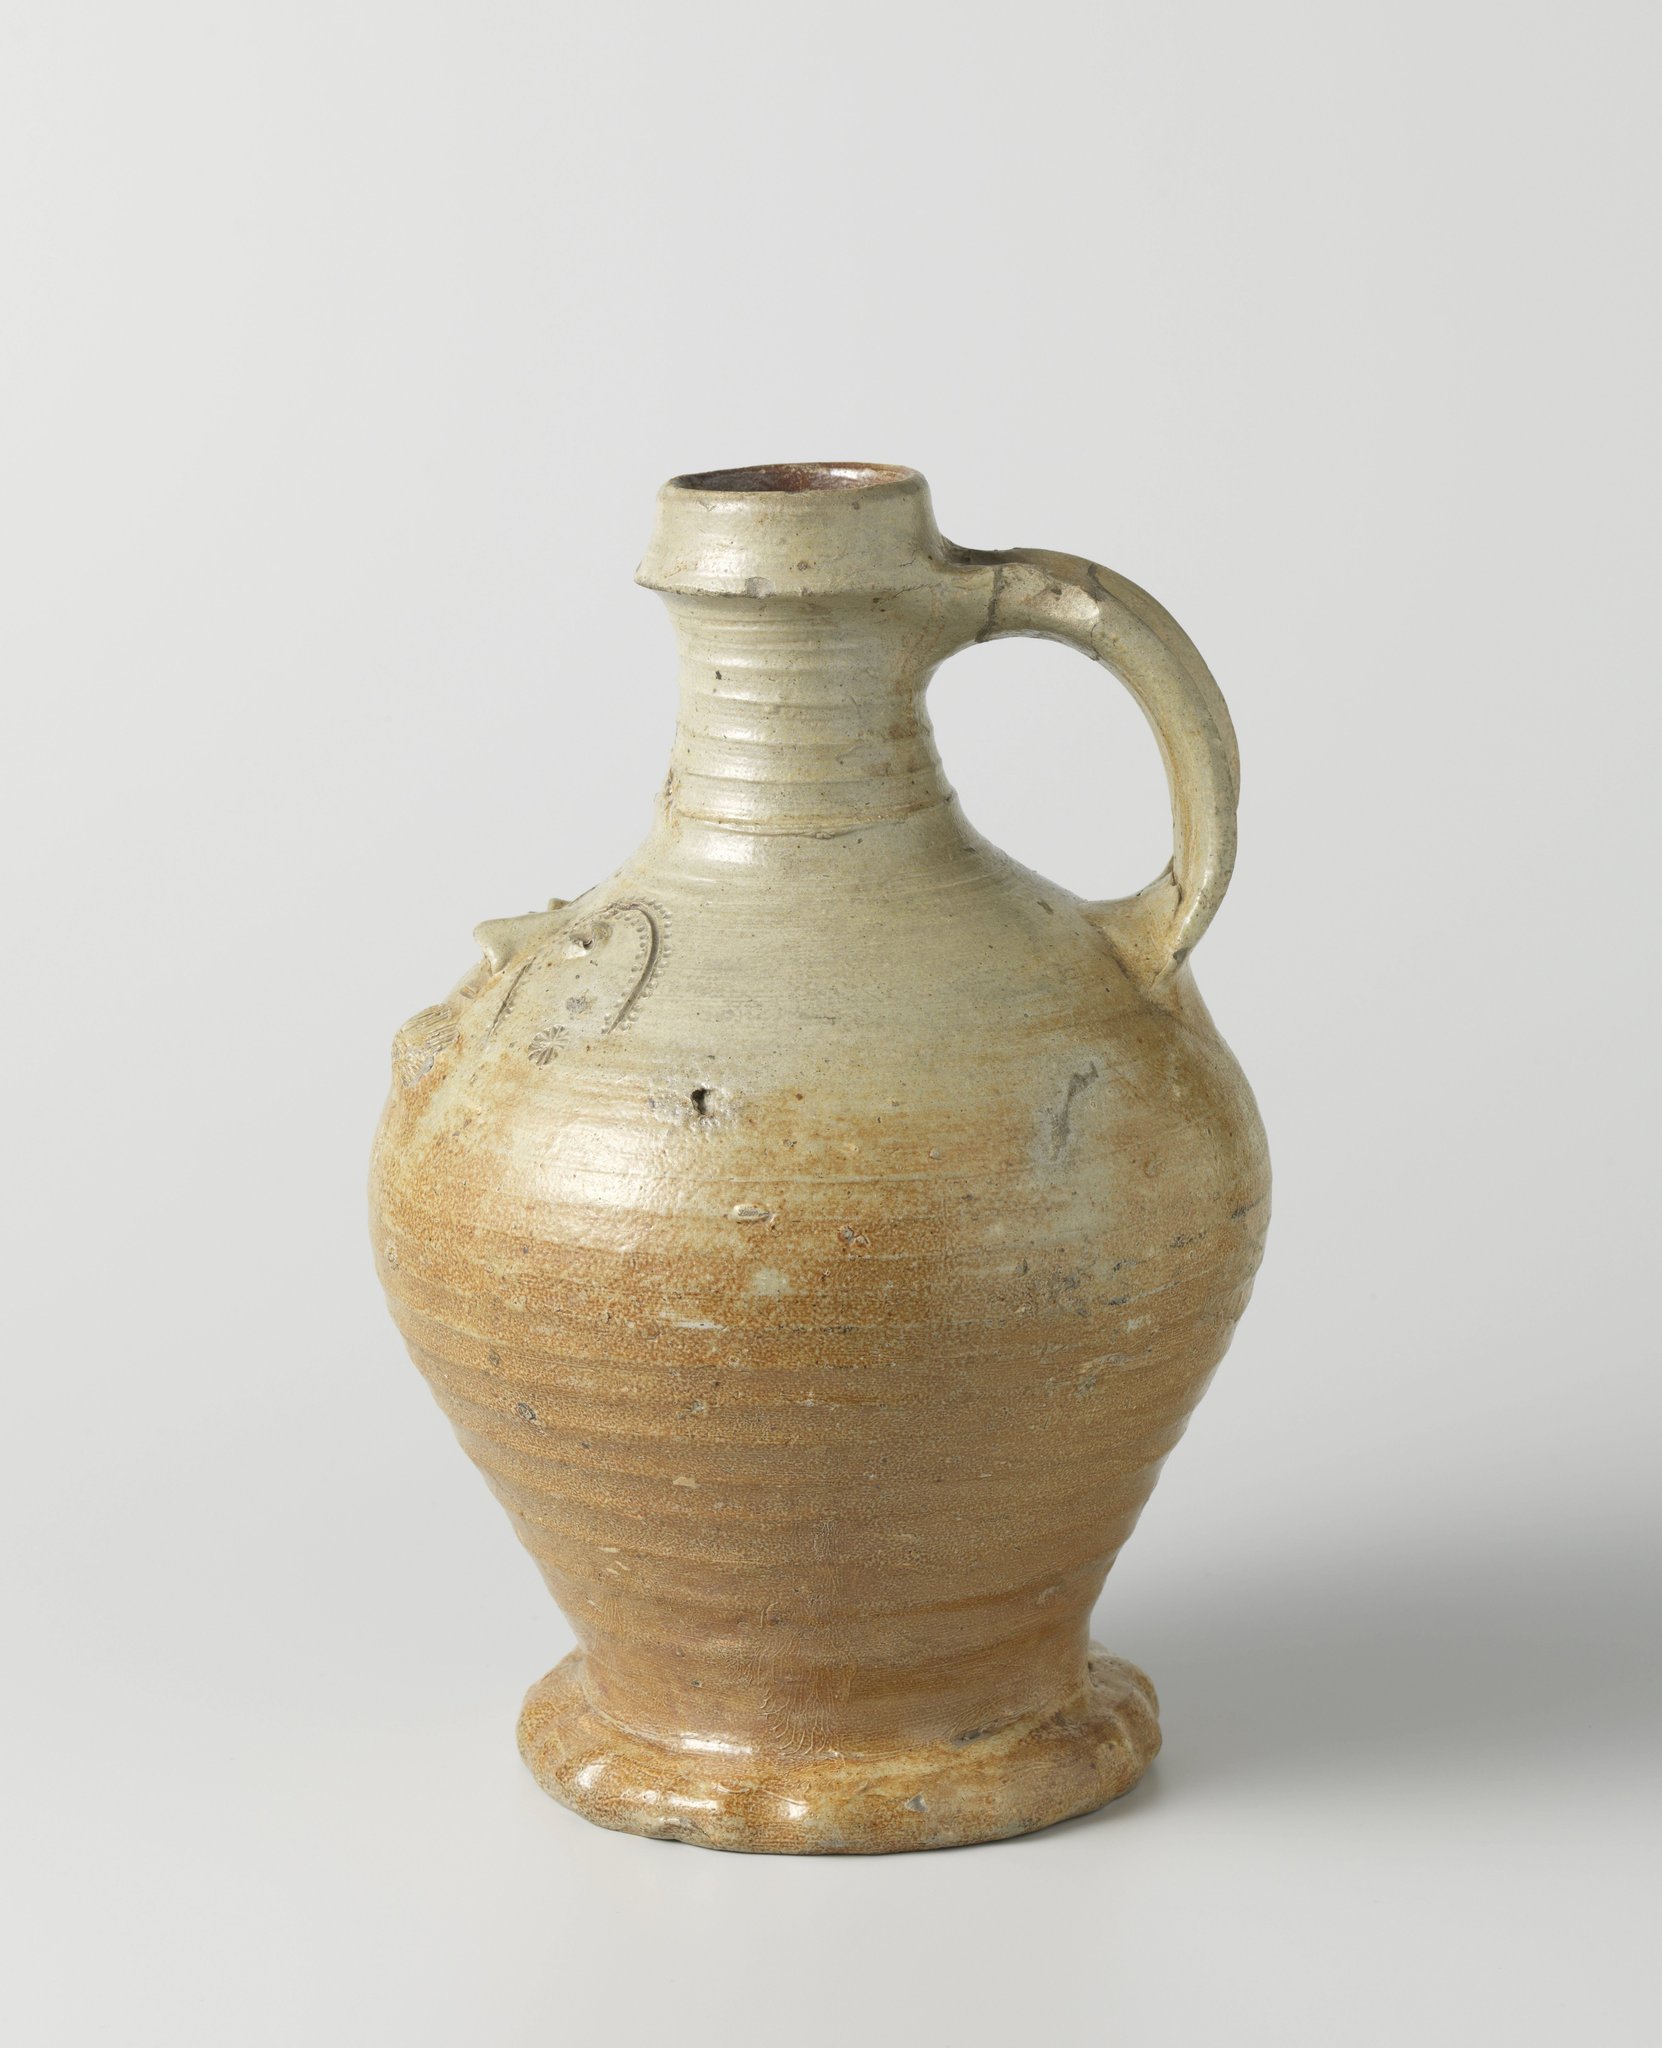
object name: face vessel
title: Jug with a face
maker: Anonymous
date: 1520-1550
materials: engobe, glaze, stoneware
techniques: printing, firing, forming, relief, turning, vitrification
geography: aachen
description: Kruik (gezichtskruik) van steengoed op golvende voet met een eivormig lichaam en smalle nek. Het C-vormige oor is bevestigd aan de nek en de schouder. Bedekt met een bruine engobe. De kan is versierd met draairingen en op de schouder met een gezicht. Het gezicht is gedeeltelijk ingegrift, gestempeld en gedrukt en opgelegd in reliëf. Aken/ Raeren.